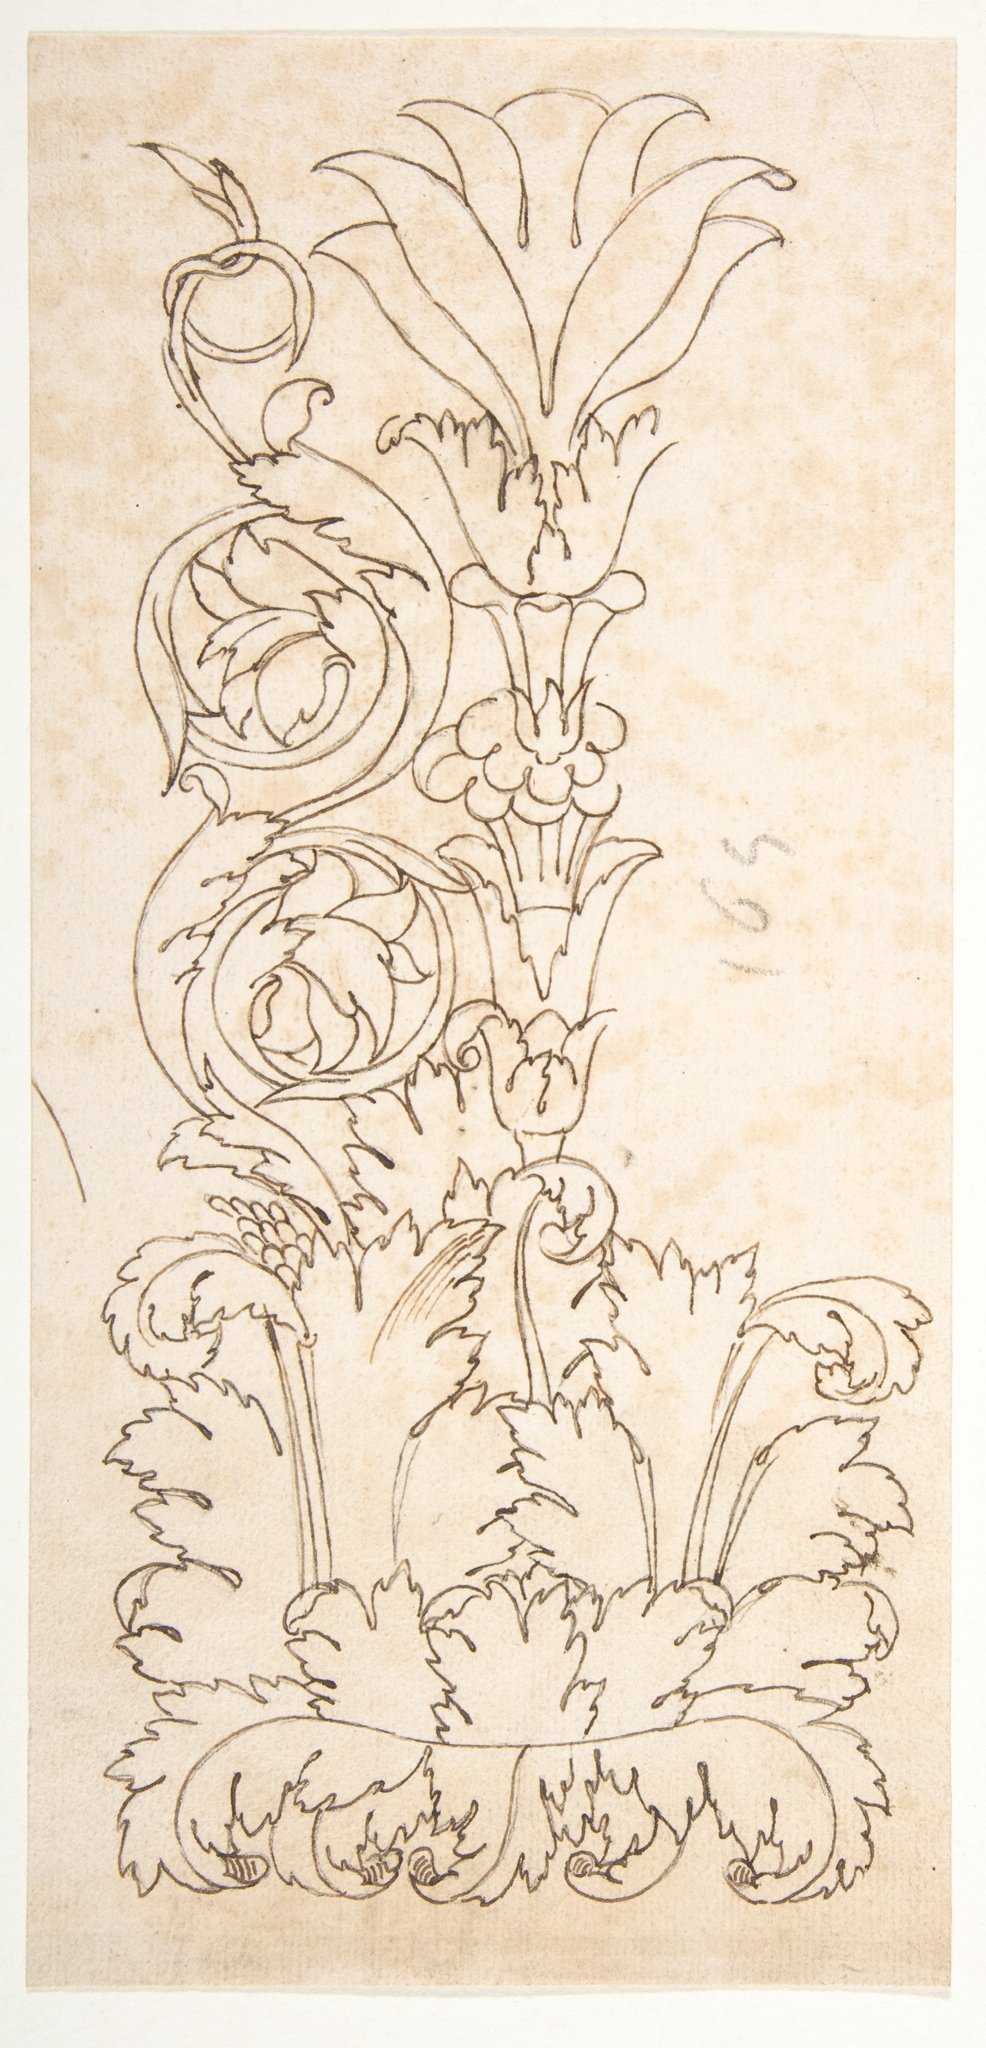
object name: collection ornament architecture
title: Ornamental drawings (recto) blank (verso)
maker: anonymous, french, 16th century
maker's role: draftsman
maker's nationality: french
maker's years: 1500-1600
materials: chalk, ink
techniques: incising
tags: ornament,flowers